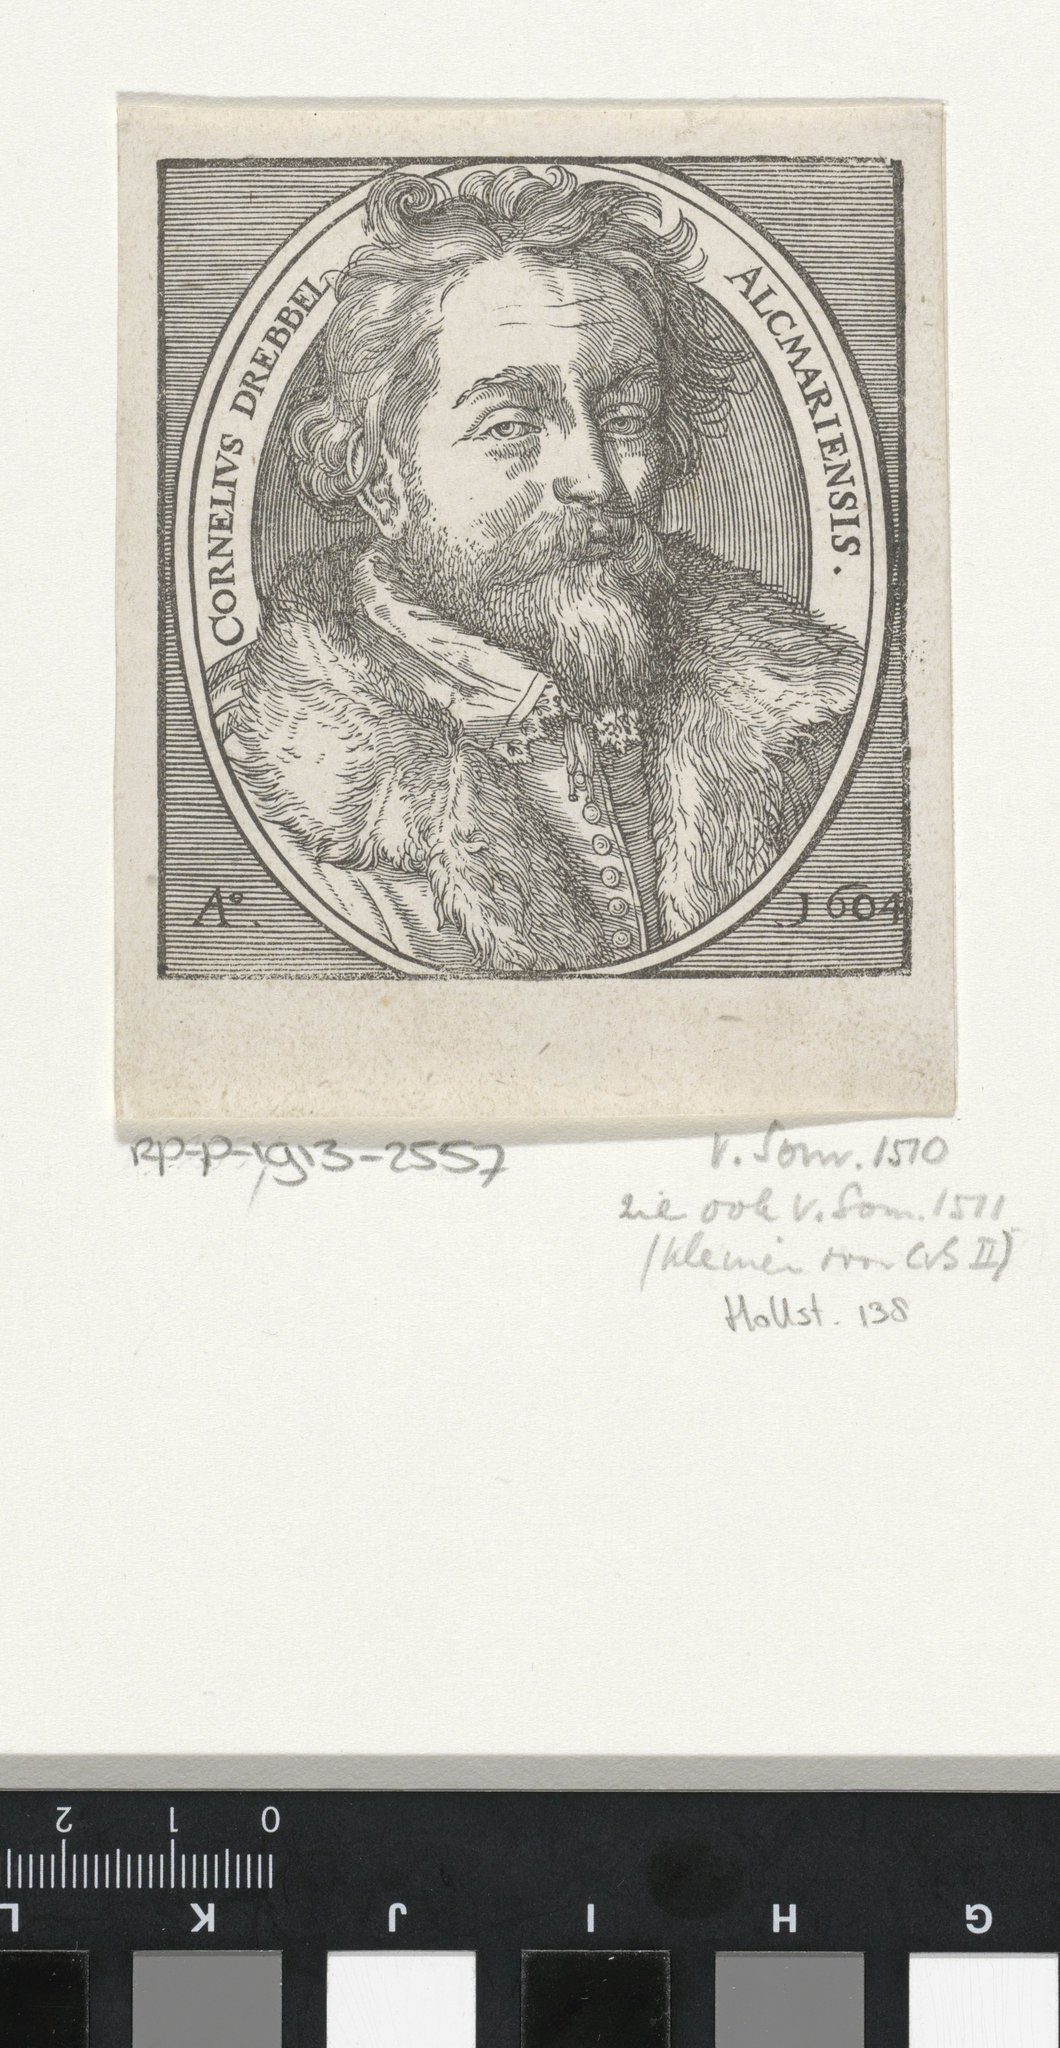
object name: print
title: Portret van Cornelis Jacobsz. Drebbel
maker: christoffel van sichem (i)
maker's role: print maker, publisher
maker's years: 1546-1624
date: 1604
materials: paper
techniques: woodcut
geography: amsterdam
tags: london, print maker, cornelis jacobsz. drebbel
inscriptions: collector's mark: Lugt 2228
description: Portret van Cornelis Jacobsz. Drebbel in een ovaal met randschrift.